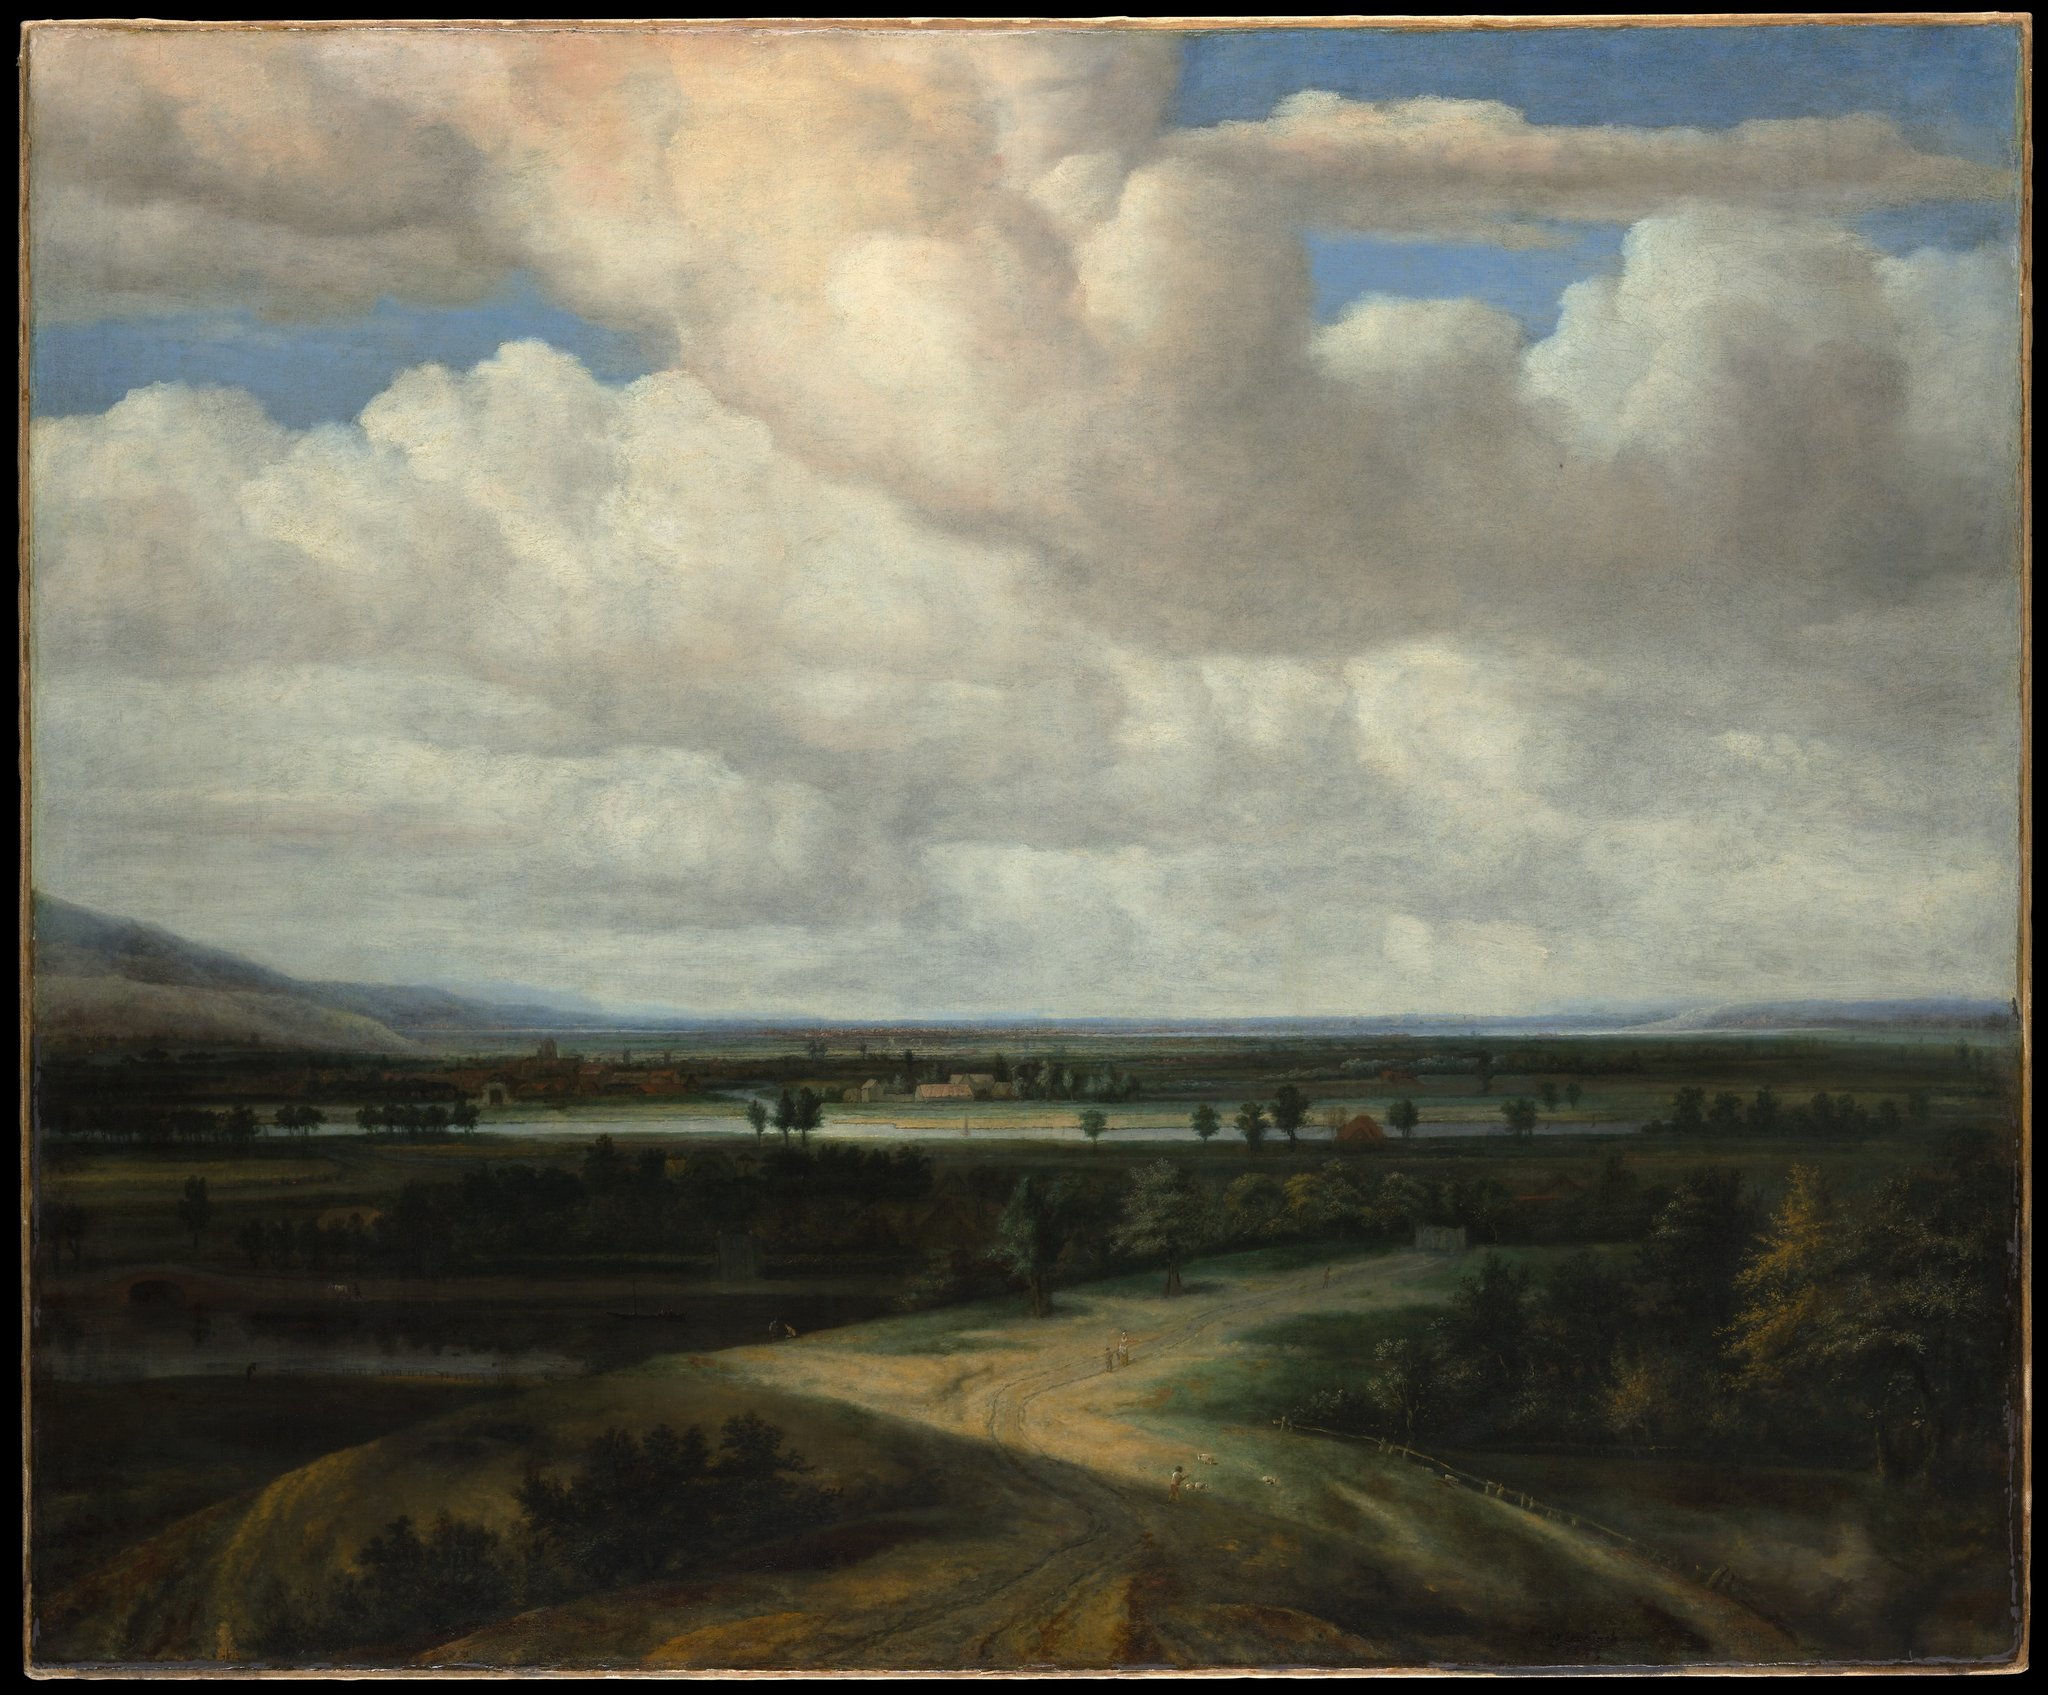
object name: painting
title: A Panoramic Landscape with a Country Estate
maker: philips koninck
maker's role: artist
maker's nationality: dutch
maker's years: 1619-1688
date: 1649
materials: canvas, oil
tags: human figures,roads,landscapes,clouds